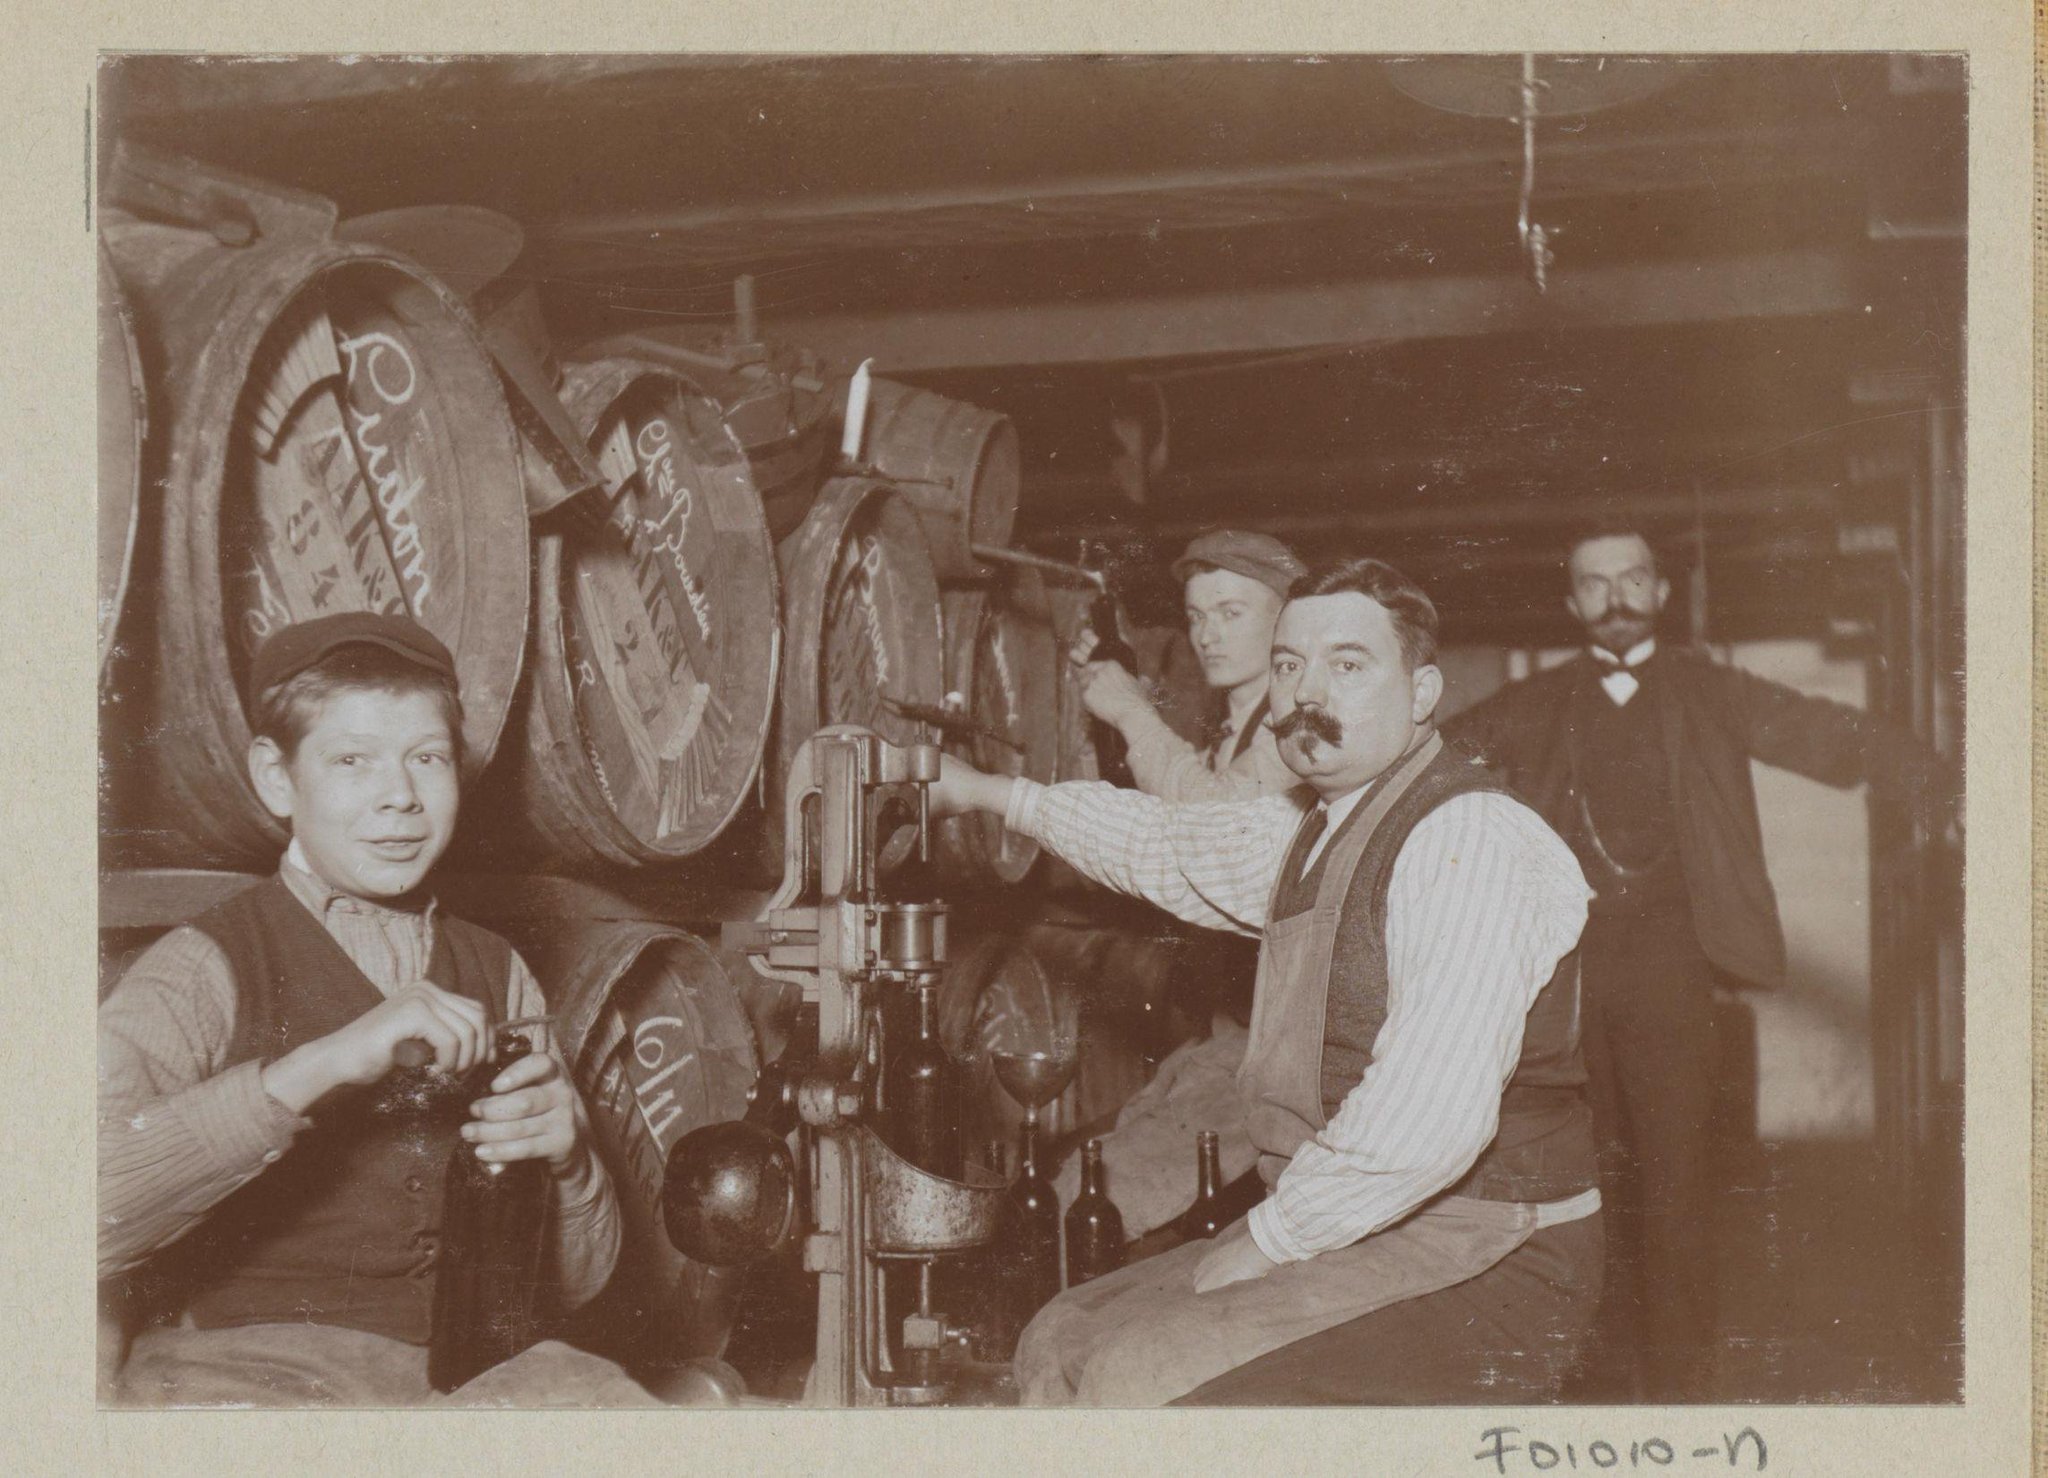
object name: photograph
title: Brouwer en bedienden bij wijnvaten en een kurkmachine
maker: Anonymous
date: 1900-1910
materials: photographic support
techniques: daylight paper print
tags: brewer, wooden container: barrel, cask (+ wood and other phytogenic material), bottling of wine (+ men (labourers))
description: Onderdeel van Familiealbum met onder meer foto's van Wijnhandel Kraaij & Co. Bordeaux-Amsterdam.